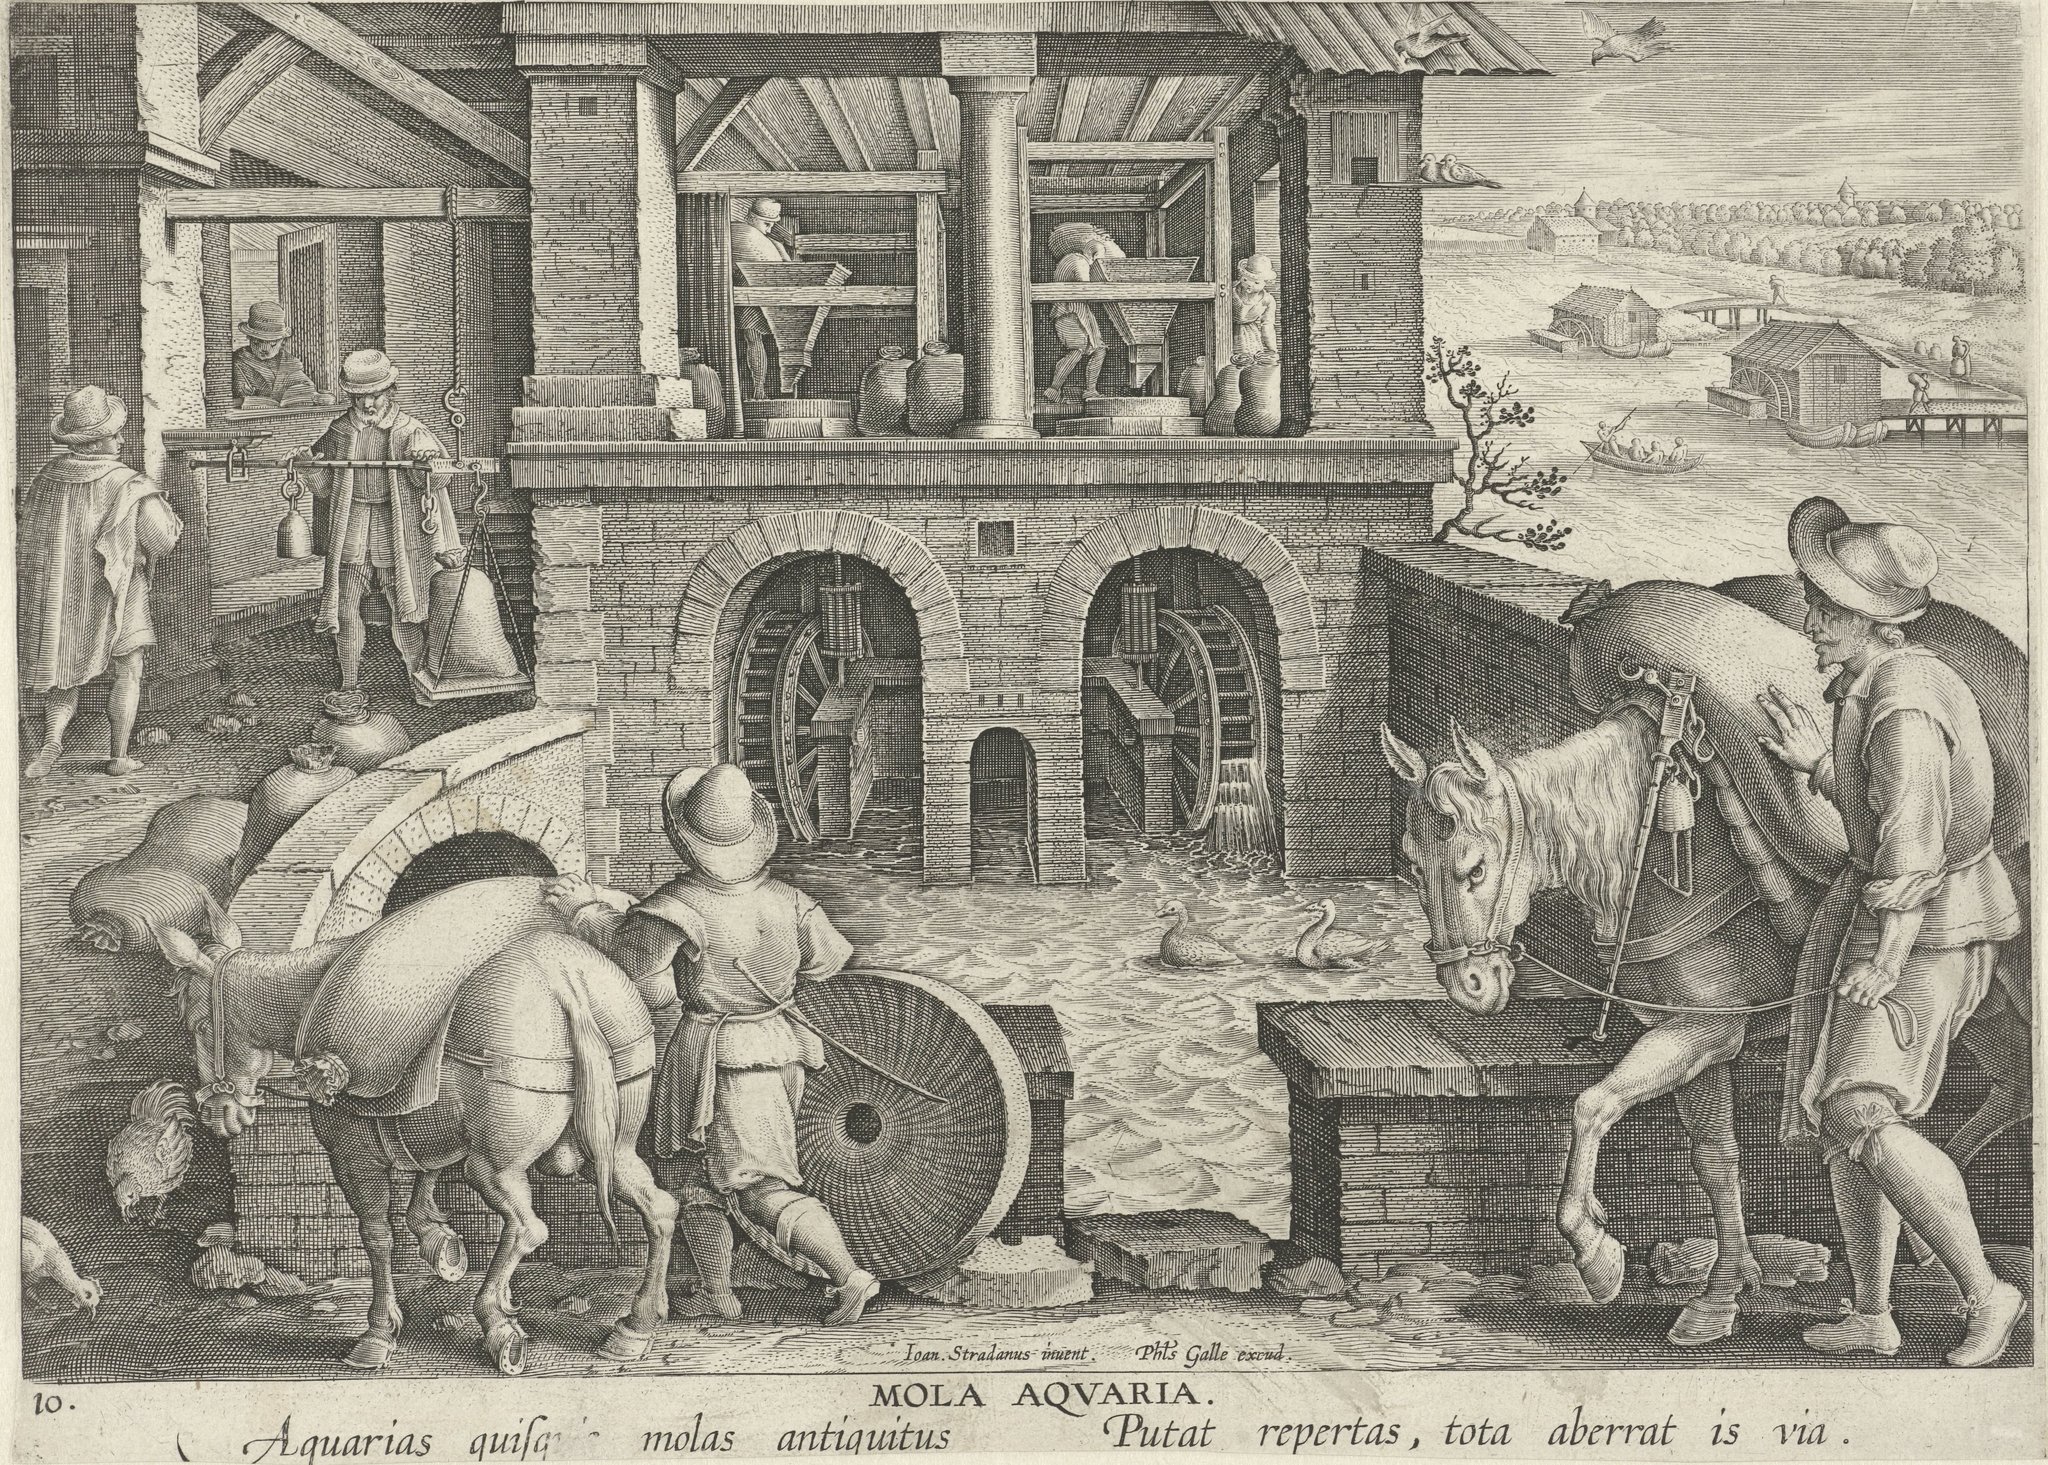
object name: print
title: Nova Reperta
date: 1589-1593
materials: paper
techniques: engraving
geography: antwerp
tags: ass, donkey, river, watermill, watermill in landscape, invention, discovery ~ science and technology, flour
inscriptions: collector's mark: Lugt 2228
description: Koren wordt in zakken naar een watermolen gebracht en daar tot meel verwerkt. Dat meel wordt vervolgens afgemeten met een weegschaal. Op de achtergrond een rivier met verschillende watermolens. De prent heeft een Latijns onderschrift en maakt deel uit van een negentiendelige serie over nieuwe uitvindingen en ontdekkingen.